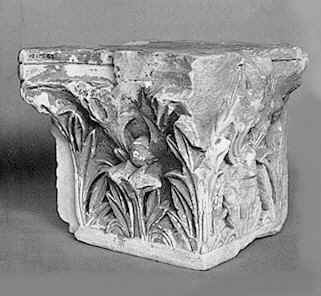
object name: capital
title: Capital with Acanthus Leaves and Traces of Red Paint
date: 501-700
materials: limestone, pigment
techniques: carving, relief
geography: egypt